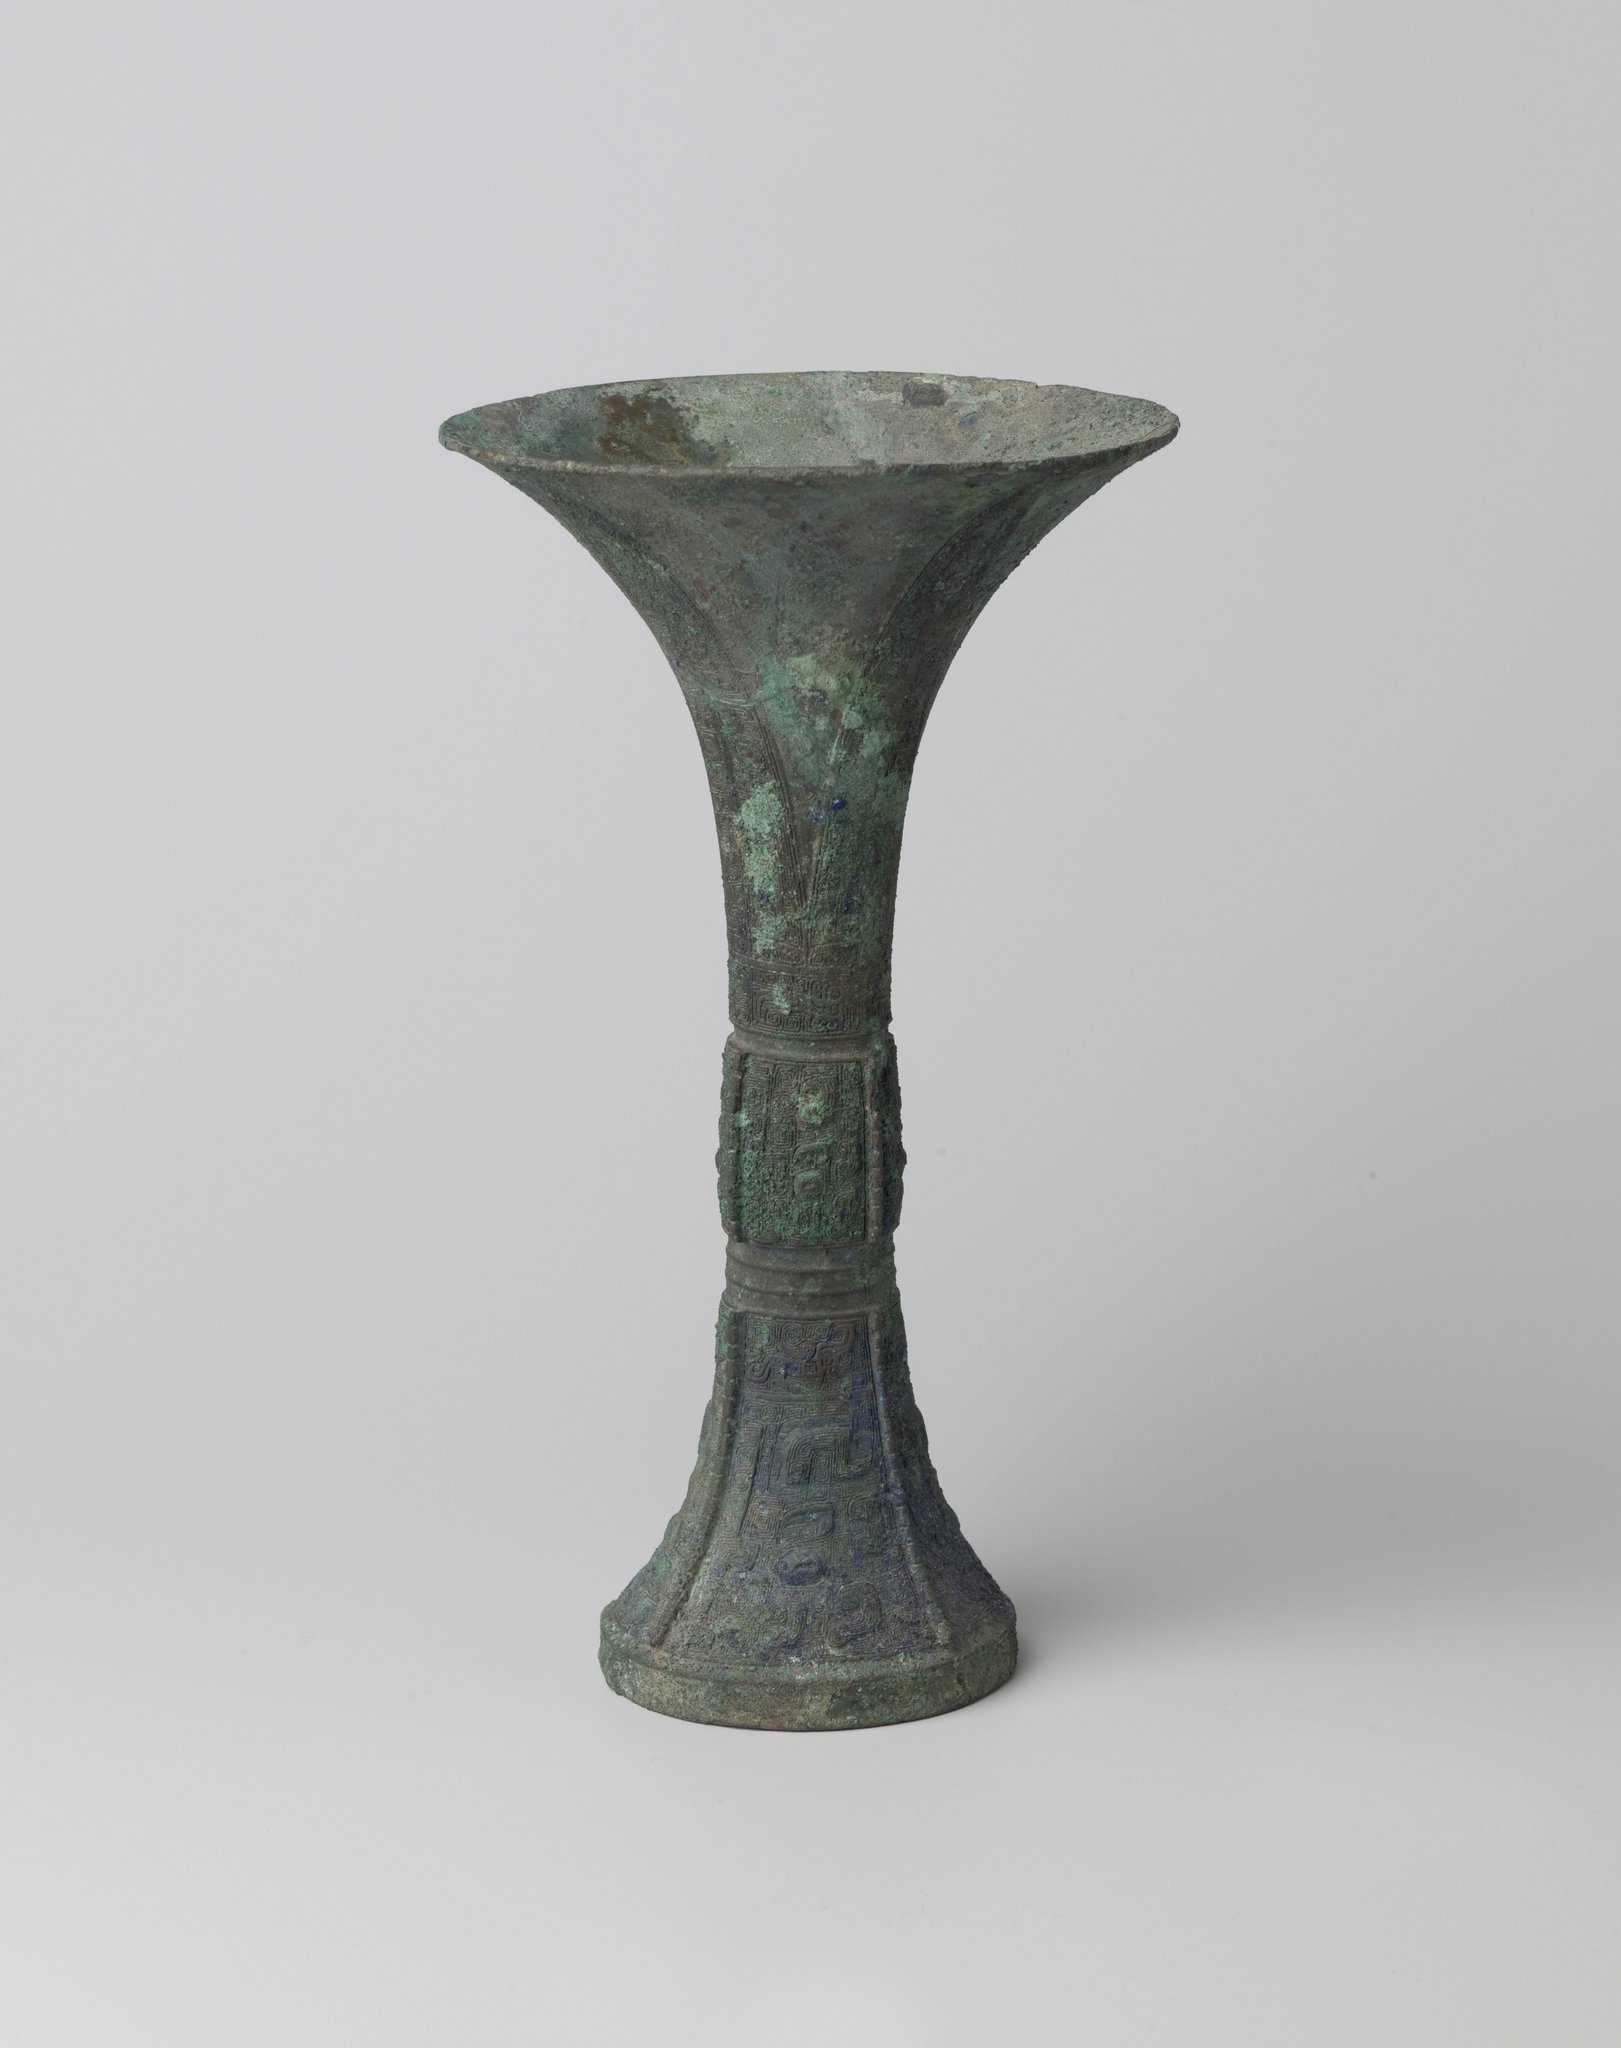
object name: wine cup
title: Tall Wine Cup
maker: Anonymous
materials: bronze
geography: china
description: Deze beker werd tijdens het offerritueel gebruikt voor wijn. Oude Chinese bronzen werden gegoten met legeringen van koper en tin, en soms ook lood. Deze materialen werden tot een vloeibare massa verhit en vervolgens met behulp van keramische mallen gegoten.